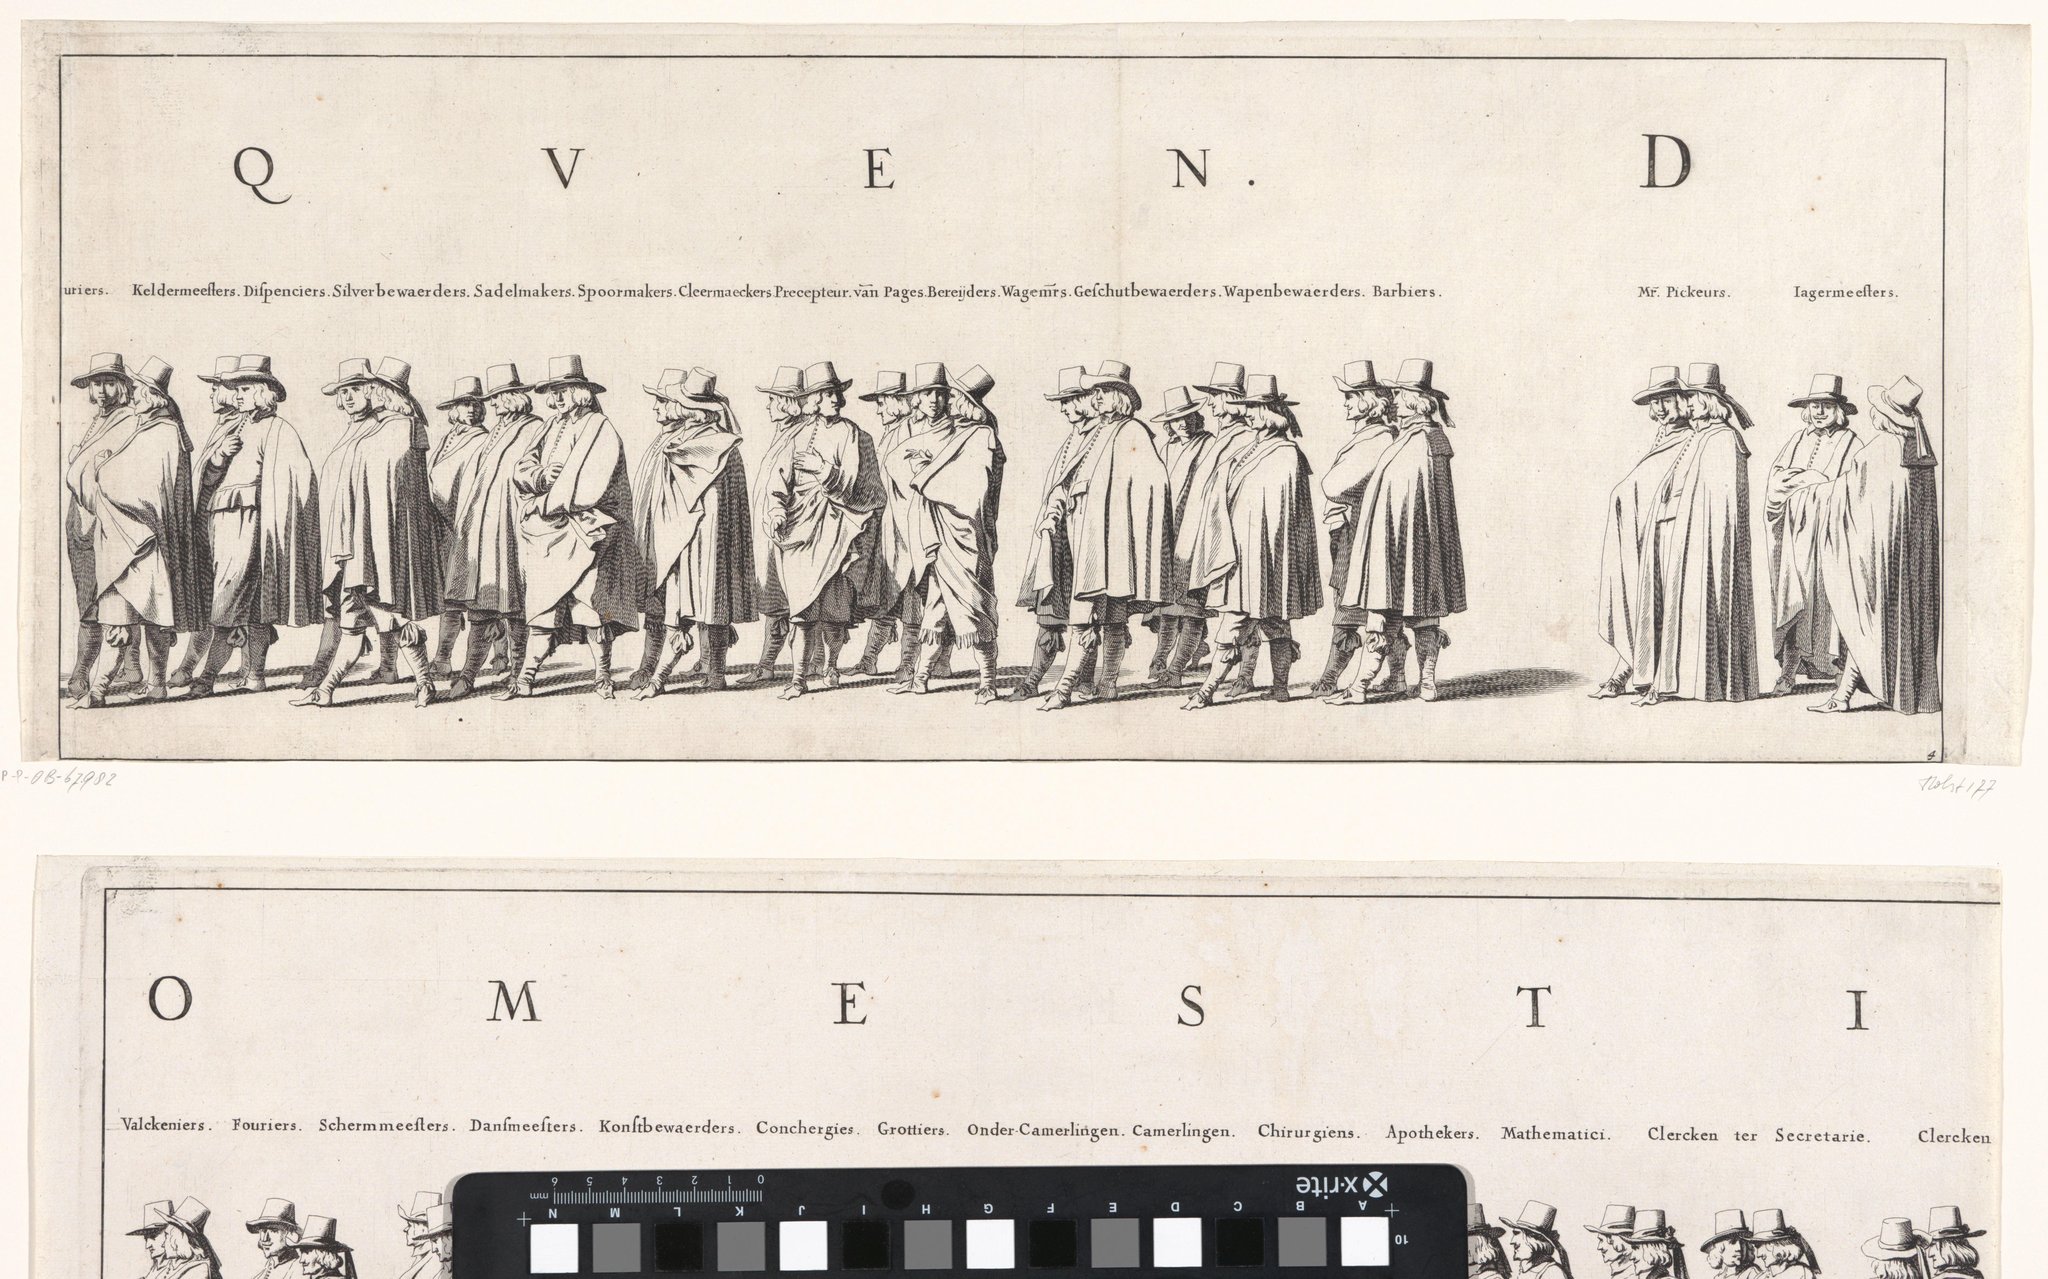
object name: print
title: Begraeffenisse van Syne Hoogheyt Frederick Henrick, by der Gratien Gods Prince van Orange, Grave van Nassau &c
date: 1647-1651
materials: paper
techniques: etching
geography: northern netherlands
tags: delft, the hague, frederick henry (prince of orange), cortege, funeral procession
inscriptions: collector's mark: Lugt 2228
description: De begrafenisstoet van stadhouder Frederik Hendrik te 's-Gravenhage op 10 mei 1647. Plaat nr. 4 met een deel van de stoet, boven de personen staat hun functie. Onderdeel van een serie van 30 platen en 20 tekstbladen, bedoeld om aan elkaar geplakt te worden.